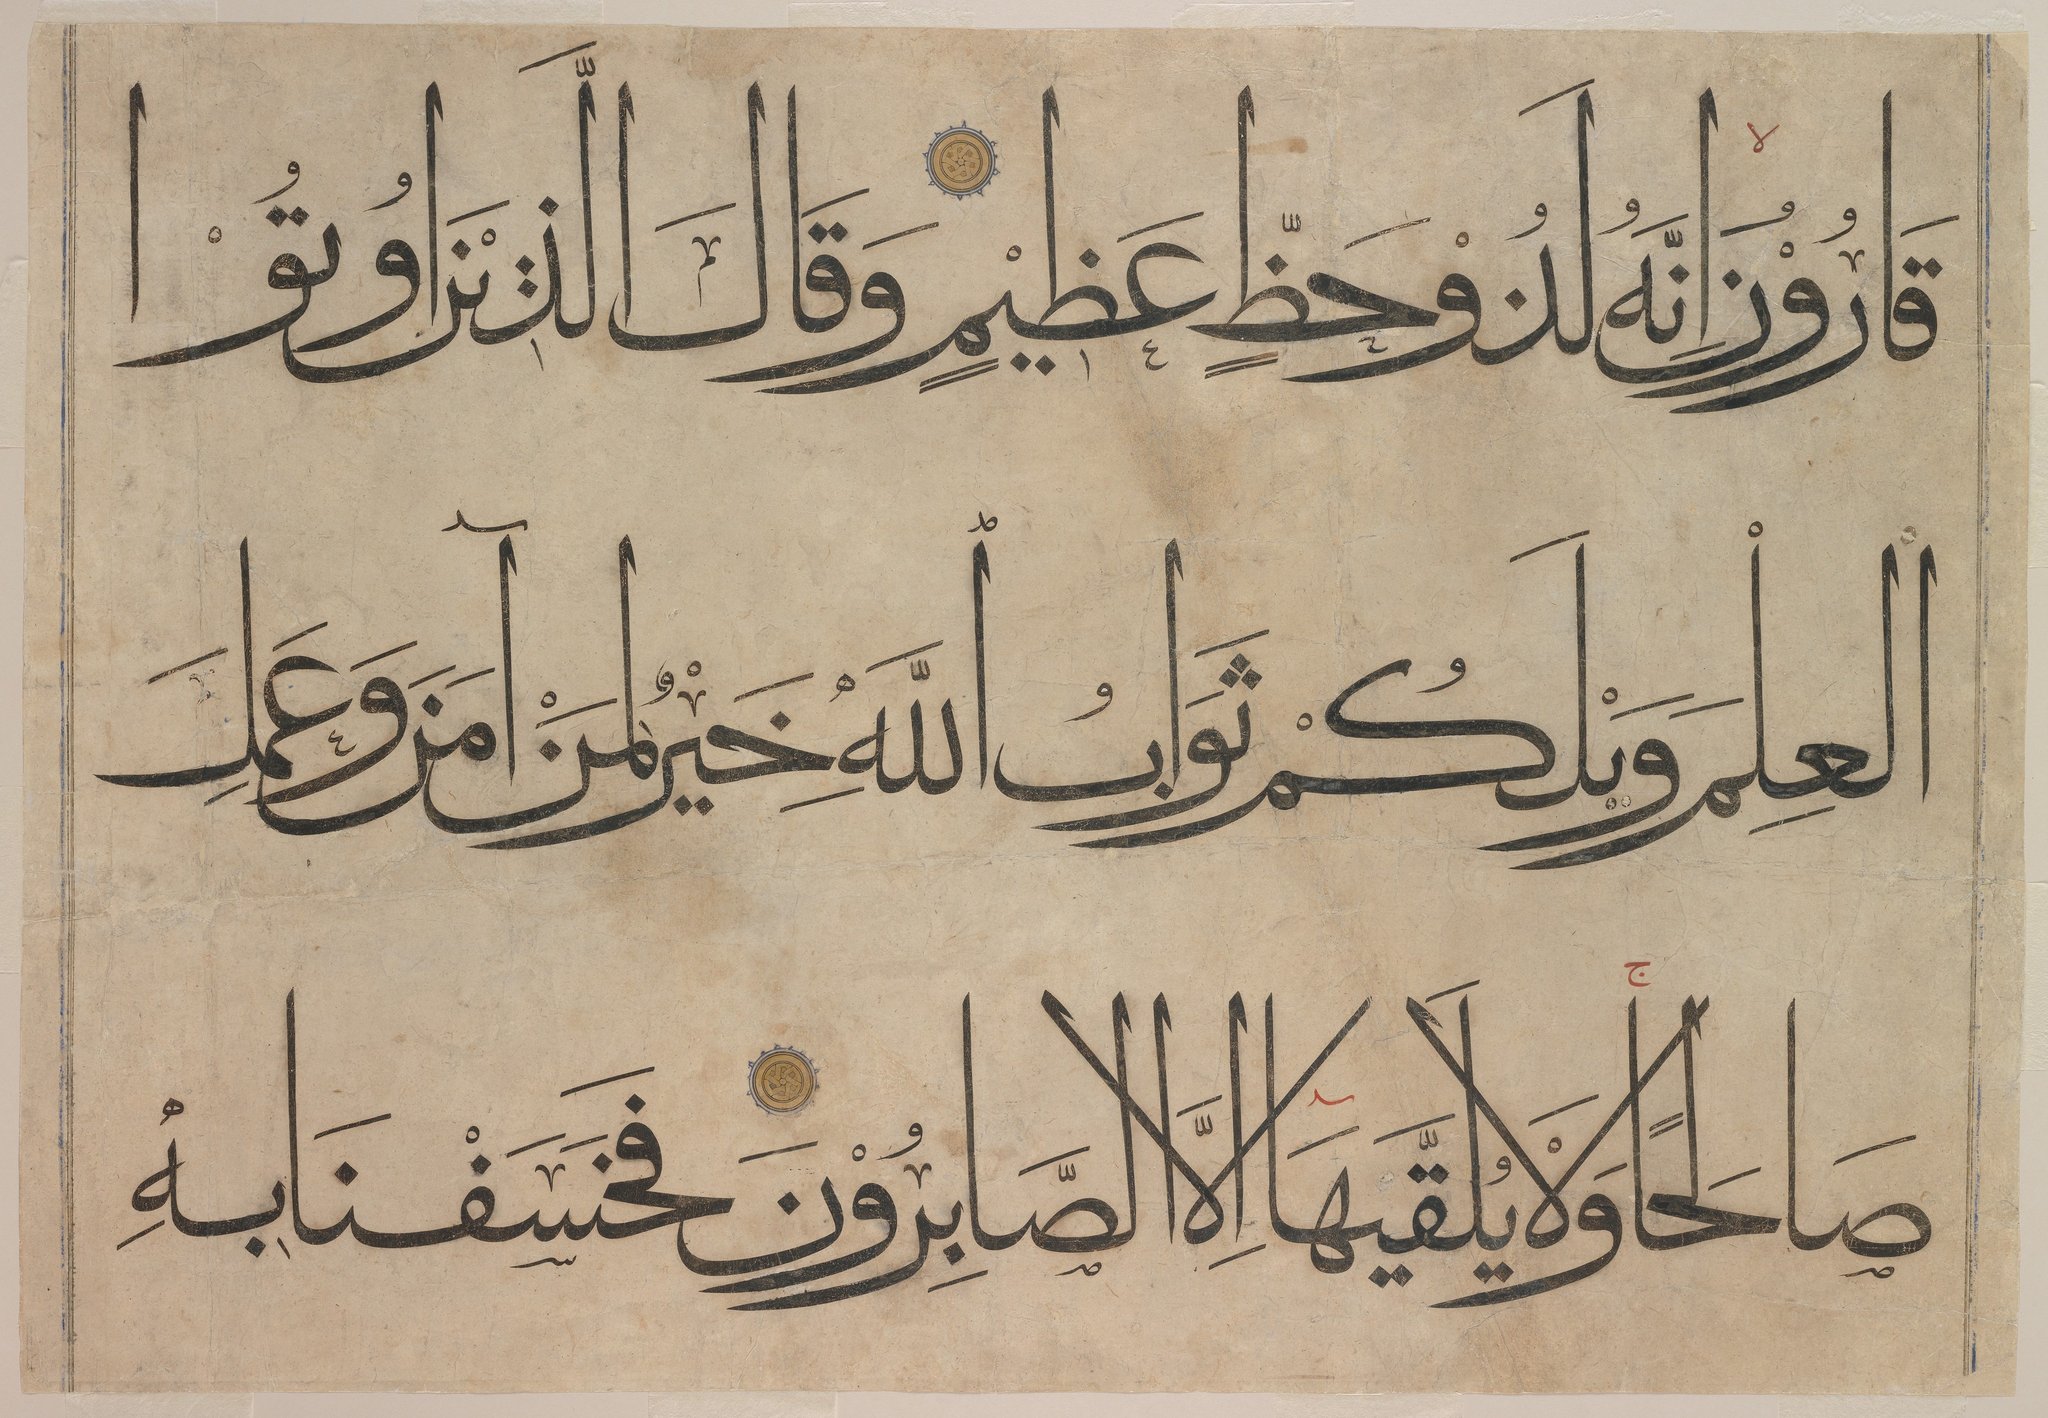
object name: section from a non illustrated manuscript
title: Section from a Qur'an Manuscript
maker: `umar aqta'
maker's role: calligrapher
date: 1367-1433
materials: gold, ink, paper, watercolor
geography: uzbekistan